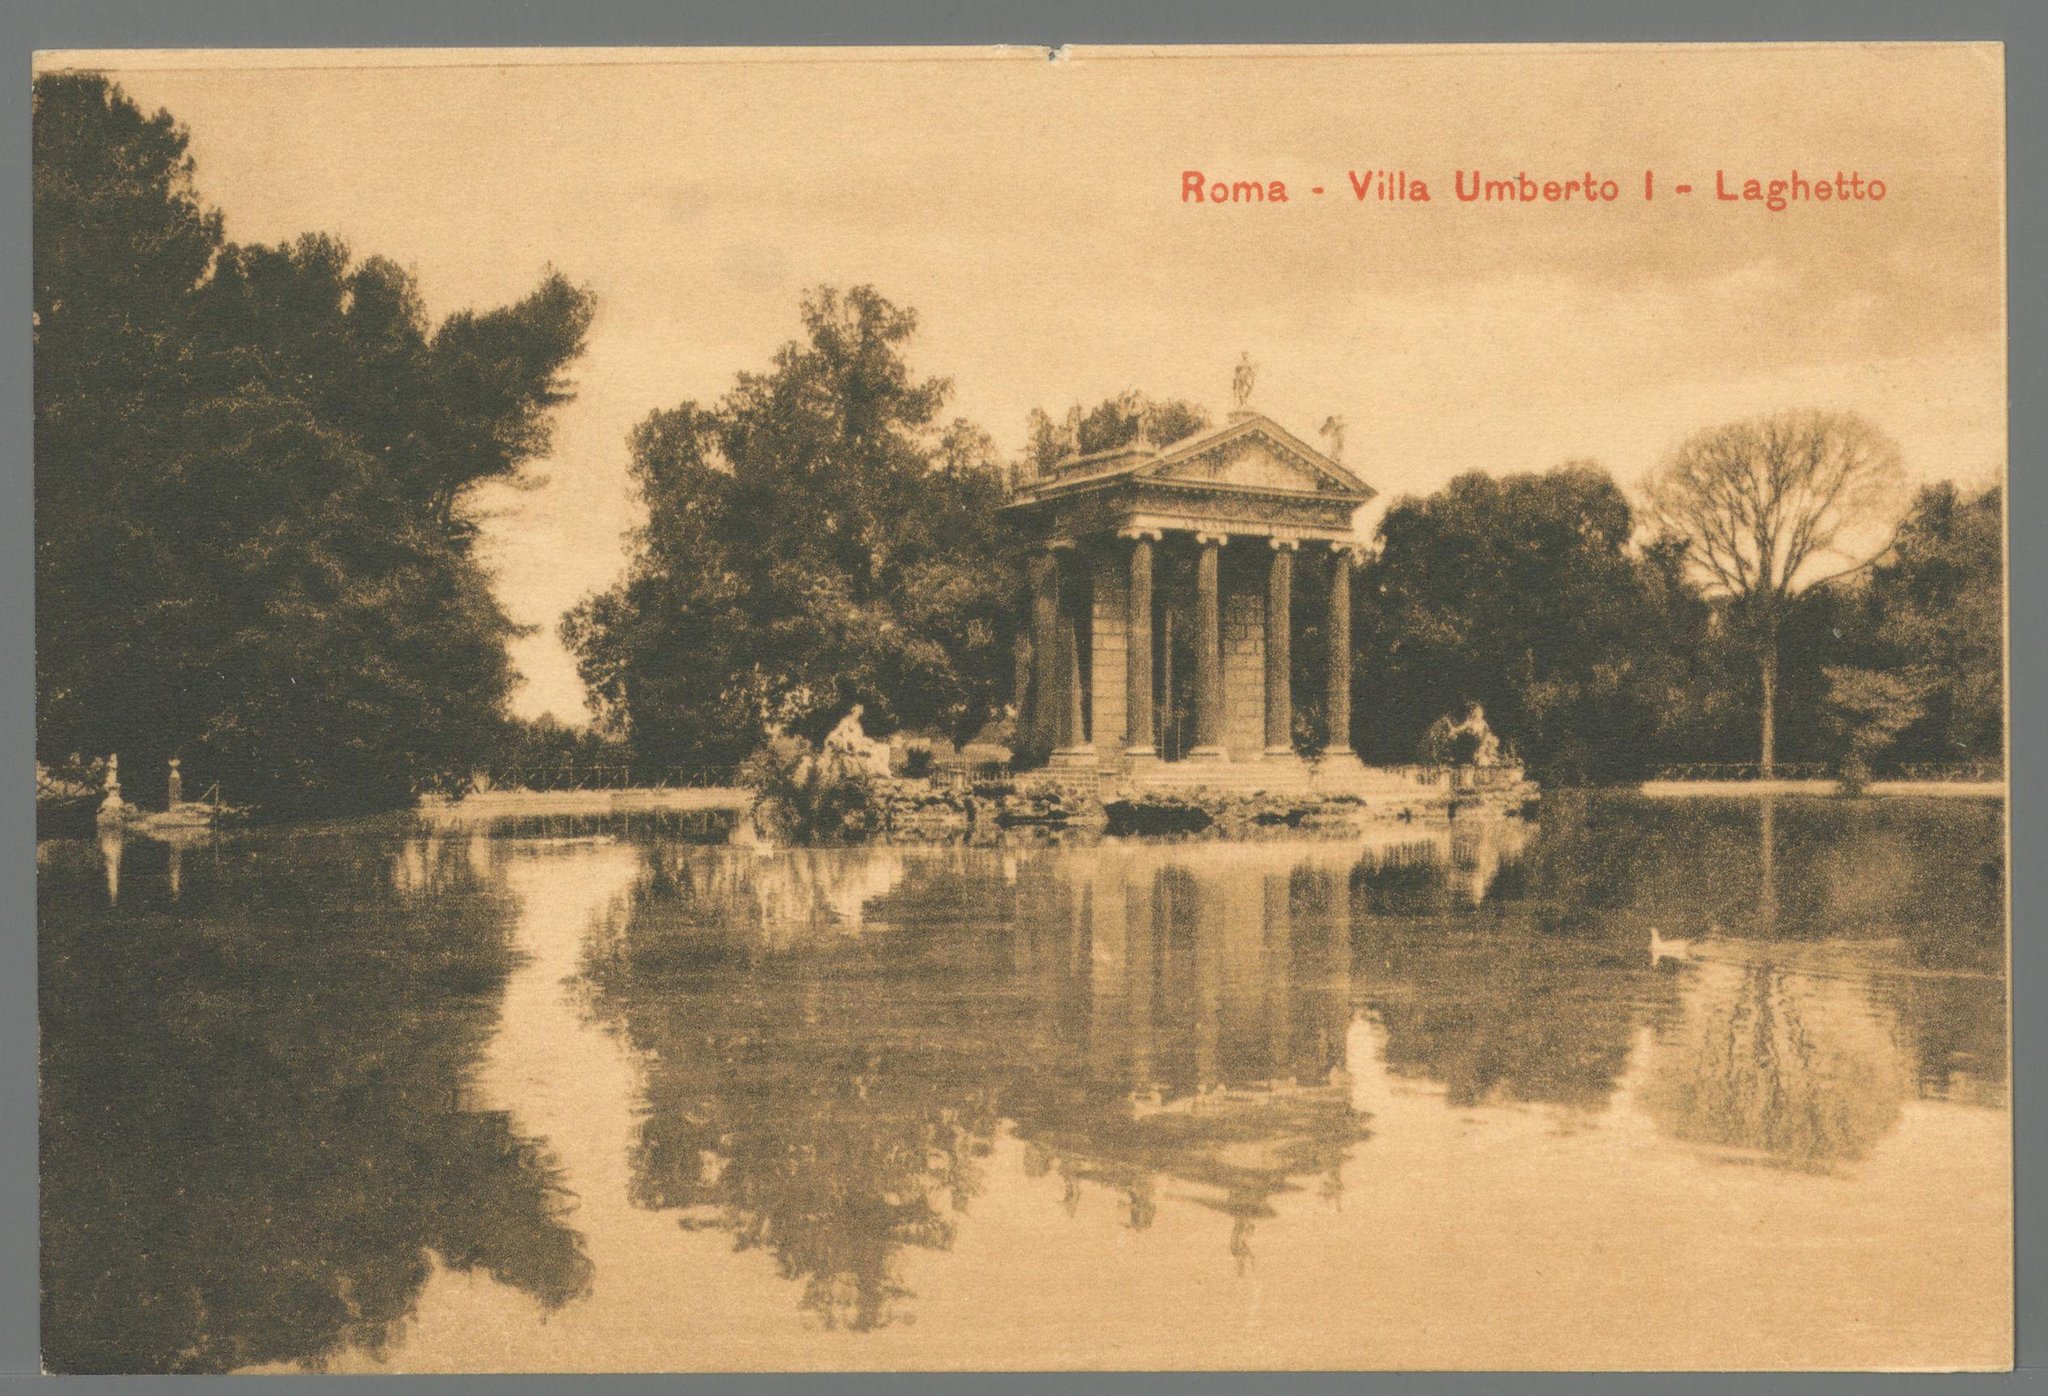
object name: ansichtkaart, prentbriefkaart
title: Roma. Villa Umberto I, laghetto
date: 1906-1920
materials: cardboard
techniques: photograph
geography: rome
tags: park, summer-house, arbour, garden-house (dutch: 'theekoepel'), garden pond, rome